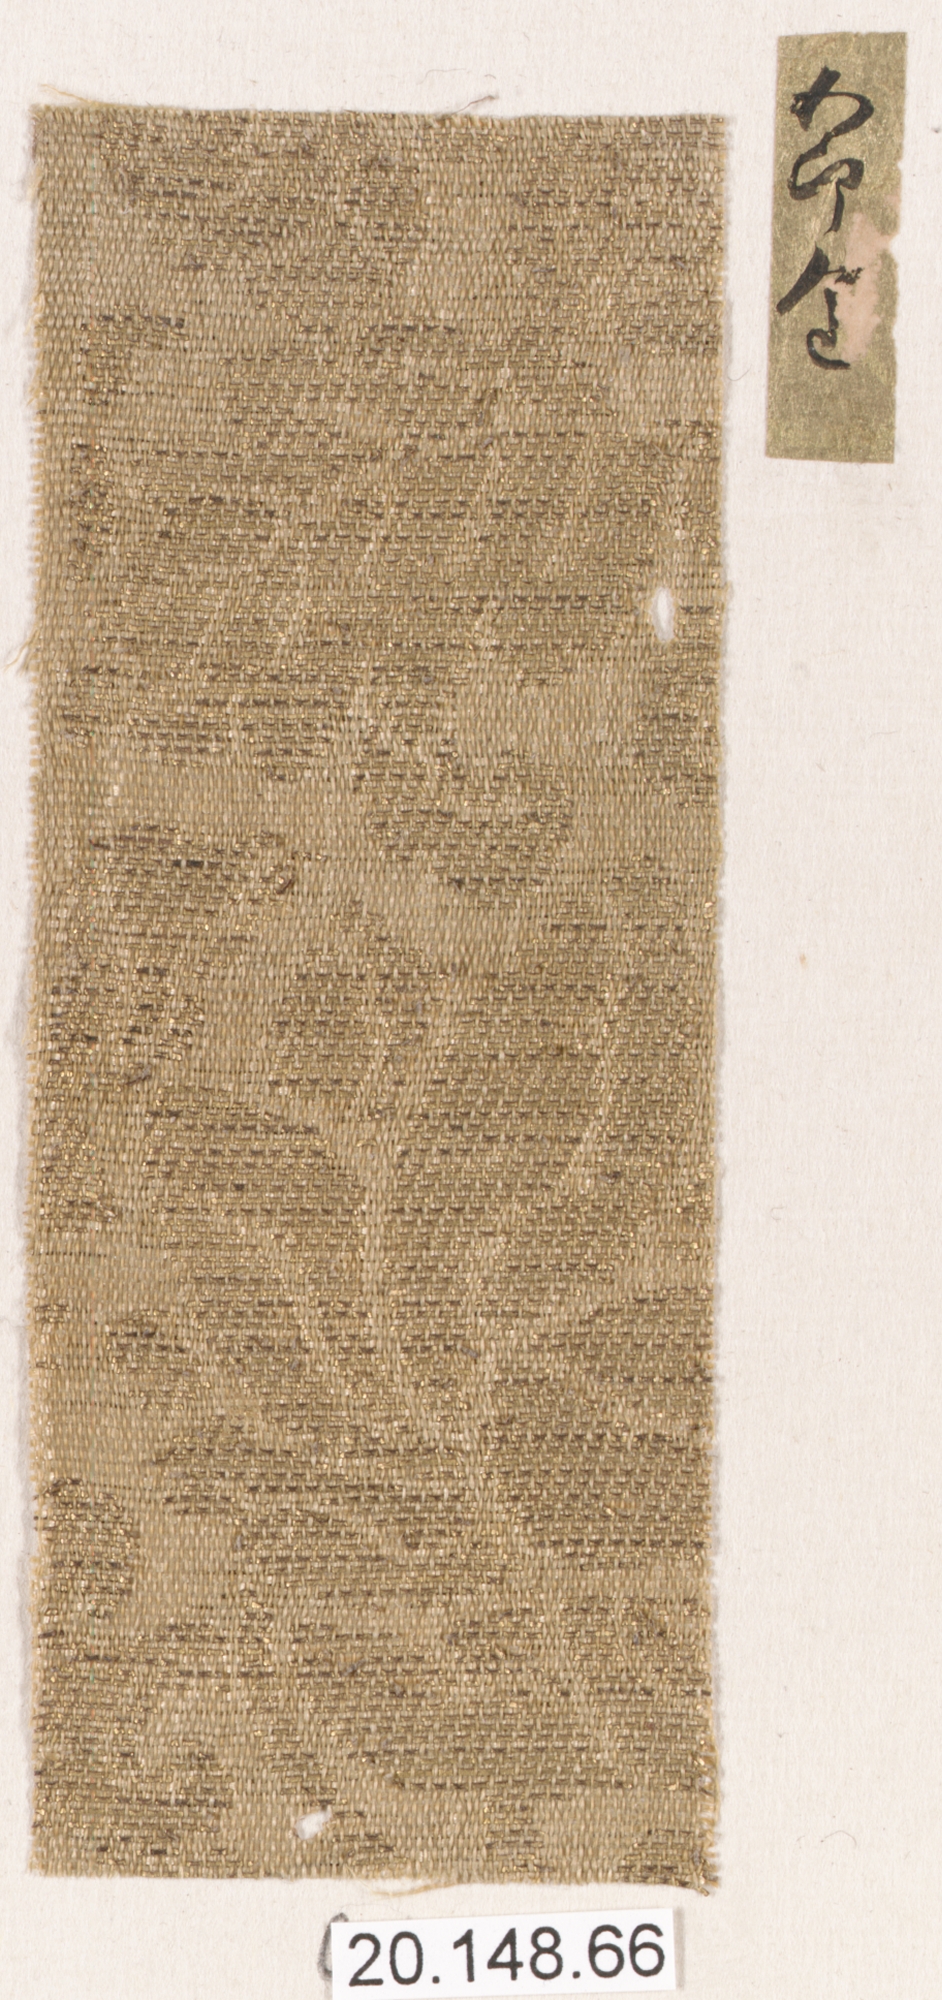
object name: piece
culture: japanese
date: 1501-1600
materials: silk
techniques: compound weave